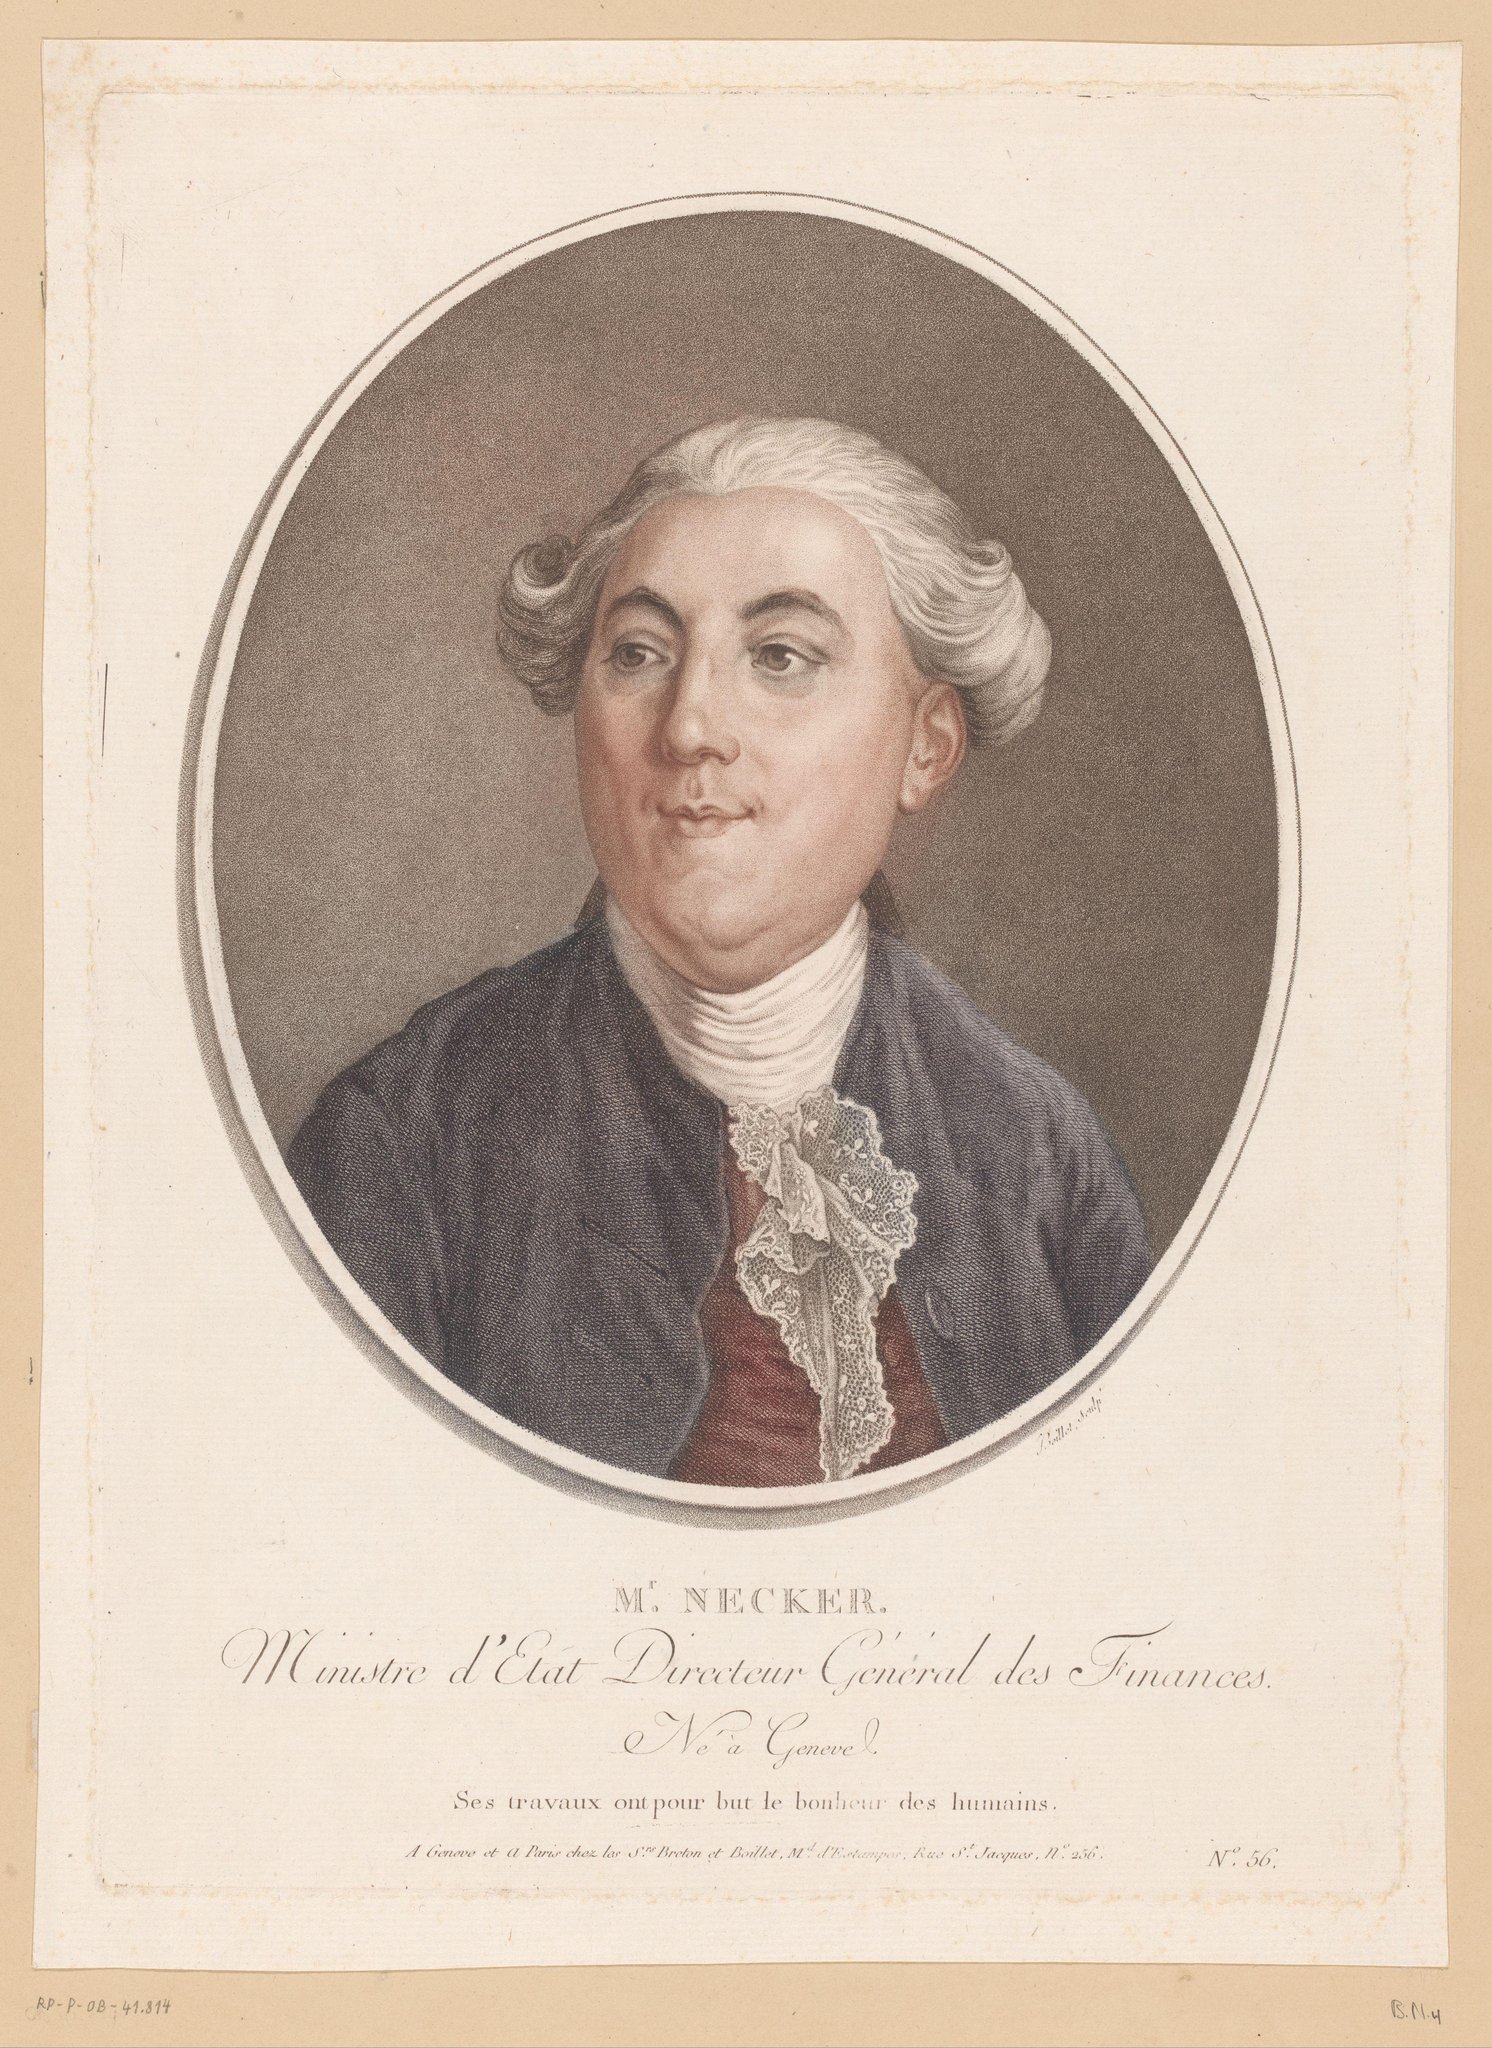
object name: print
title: Mr. Necker.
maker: j.n. boillet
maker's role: print maker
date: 1789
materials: paper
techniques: lithography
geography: france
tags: ornament ~ medallion, historical persons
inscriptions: collector's mark: Lugt 2228